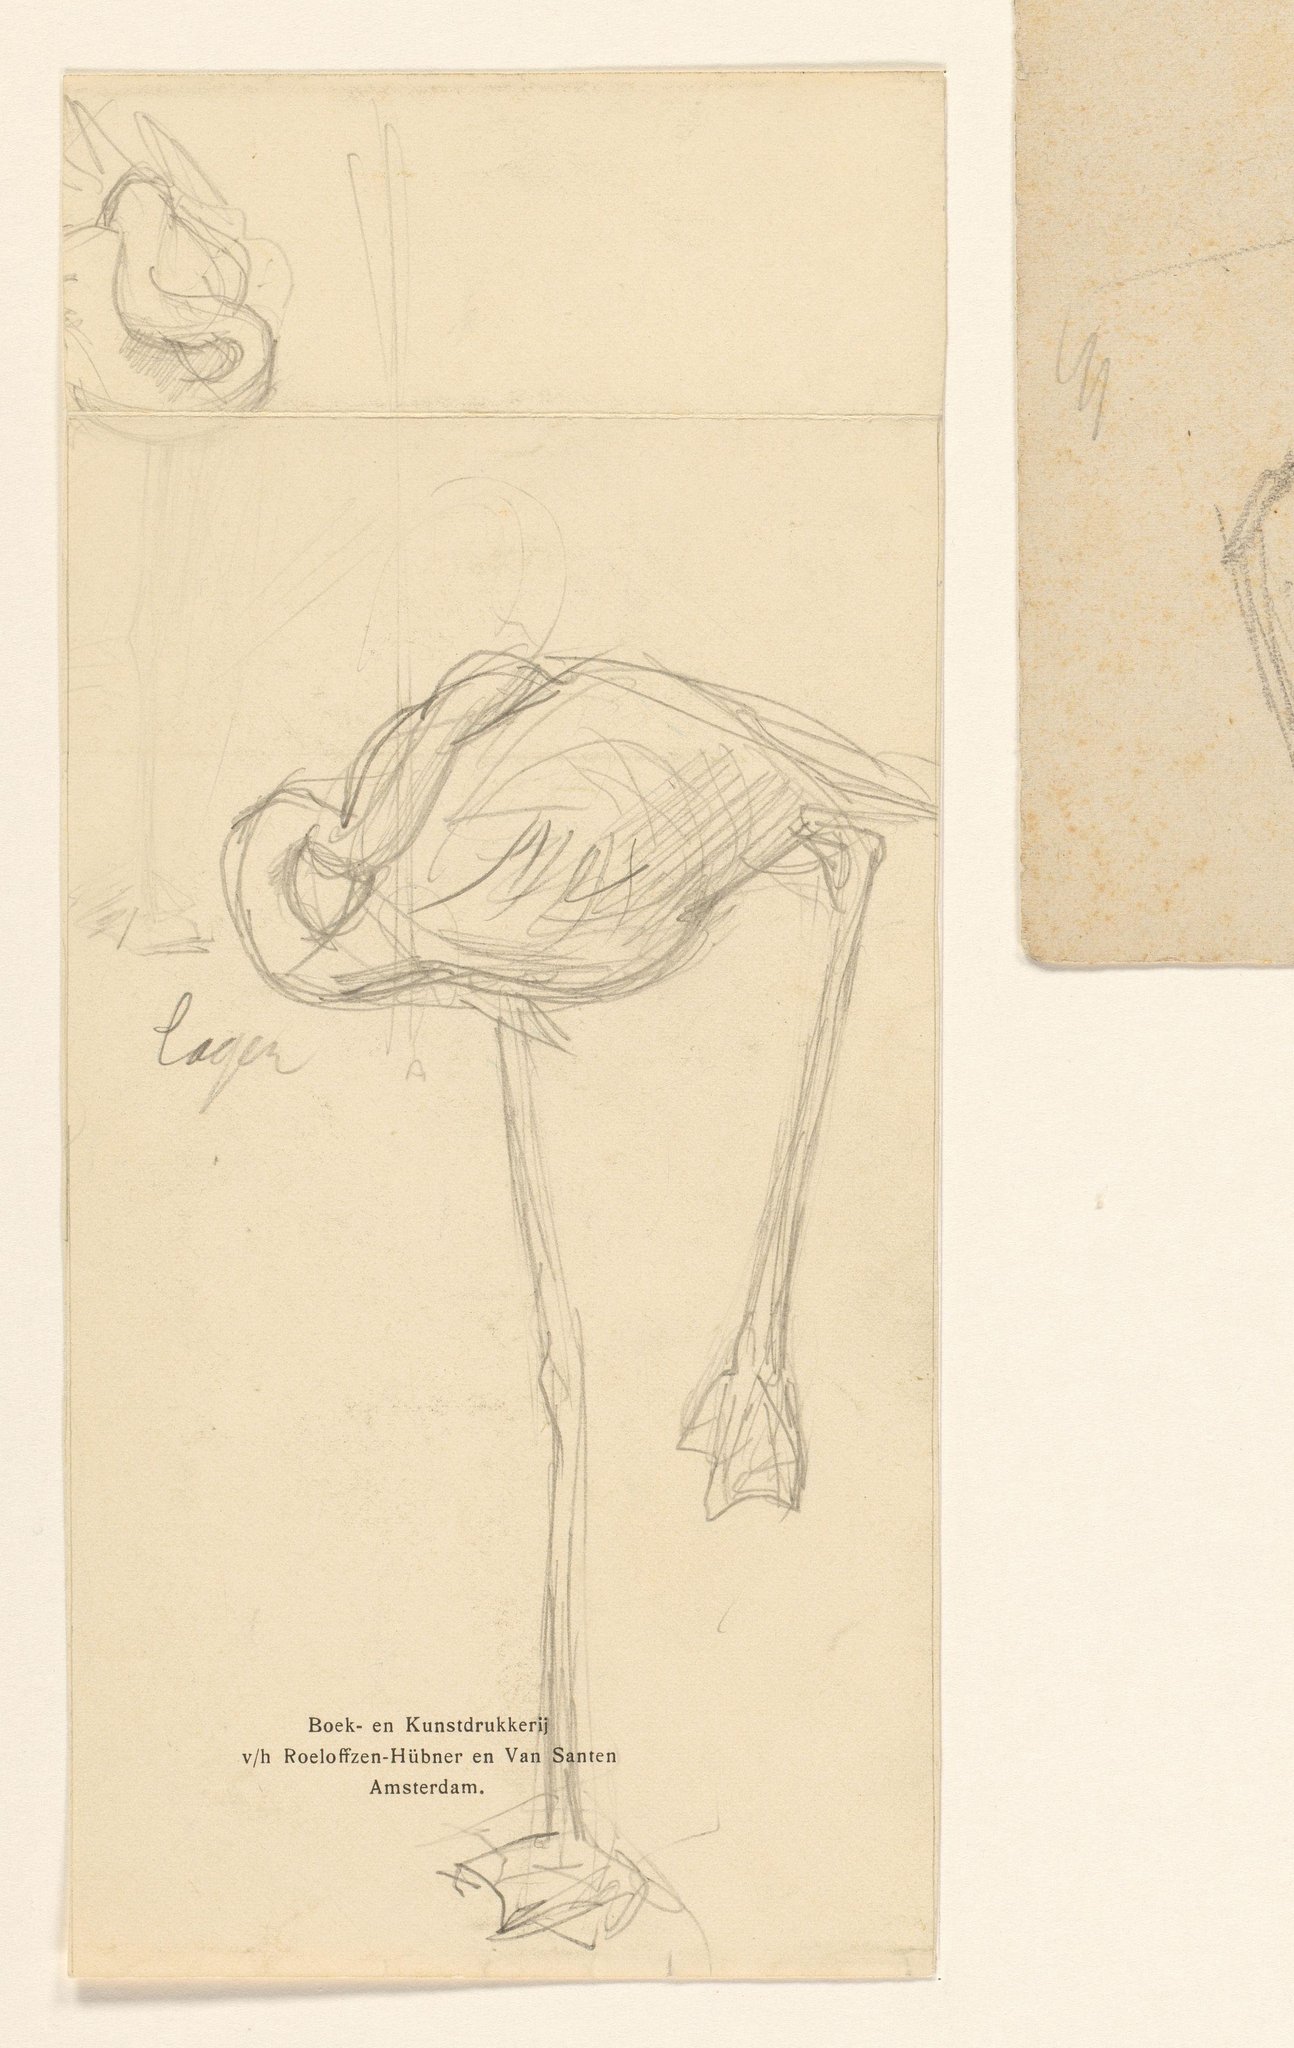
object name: drawing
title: Schetsblad met studies van flamingo's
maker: august allebé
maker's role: draughtsman, print maker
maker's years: 1838-1927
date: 1848-1927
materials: paper, pencil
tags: shore-birds and wading-birds: flamingo